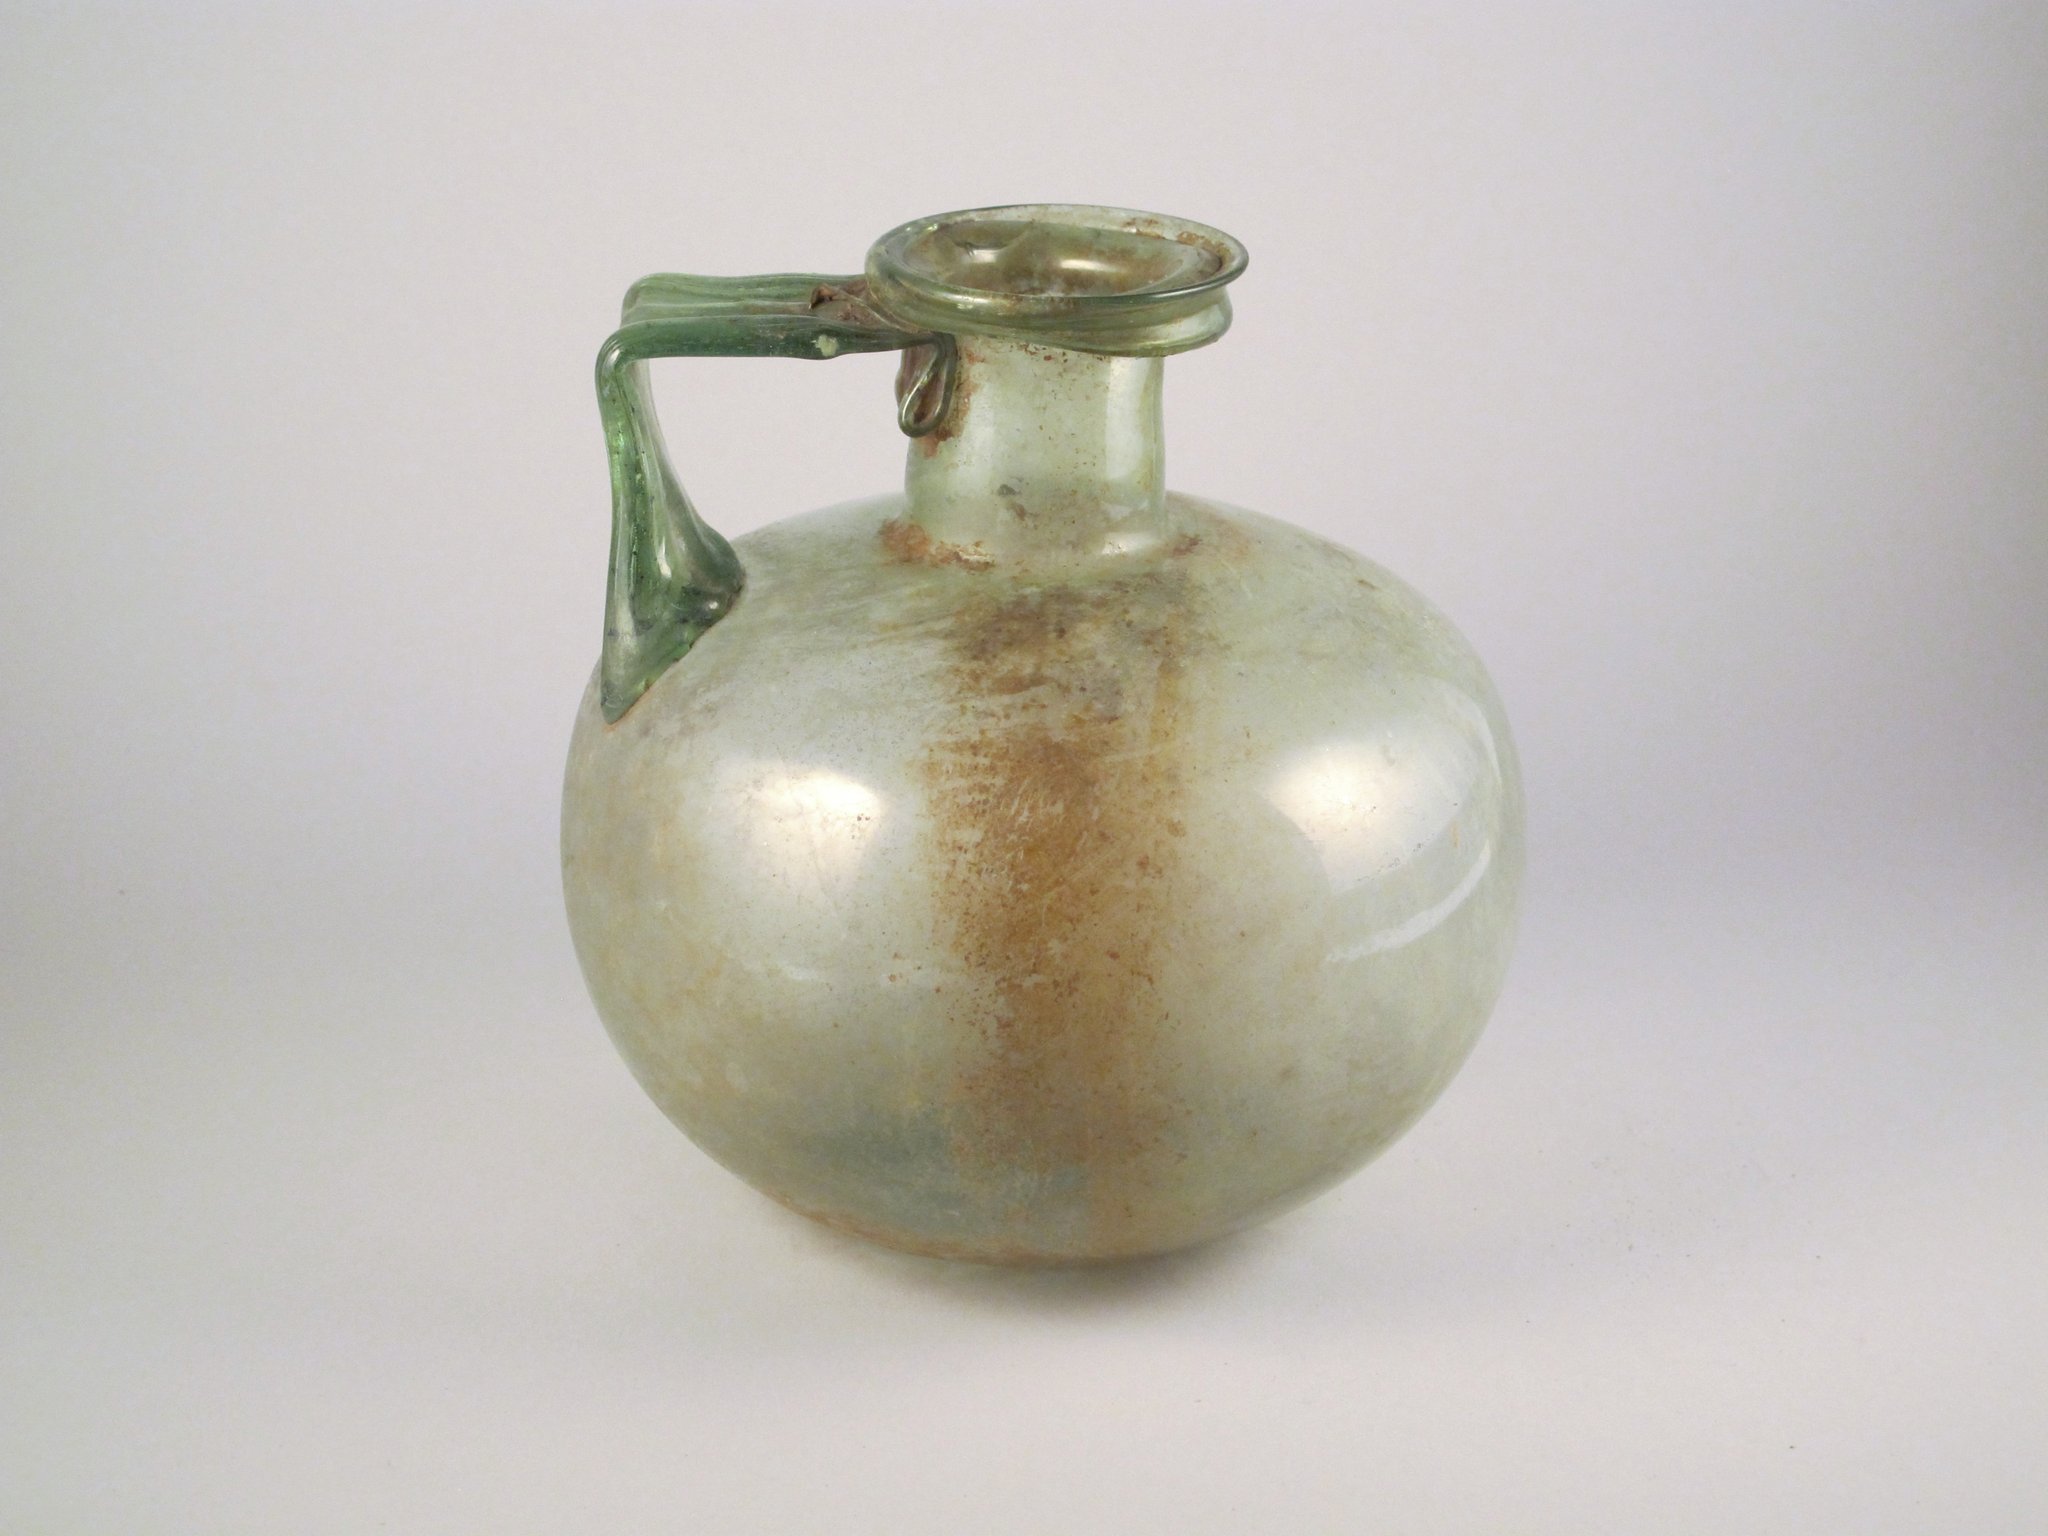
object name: jug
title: Glass jug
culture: roman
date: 1-200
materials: glass